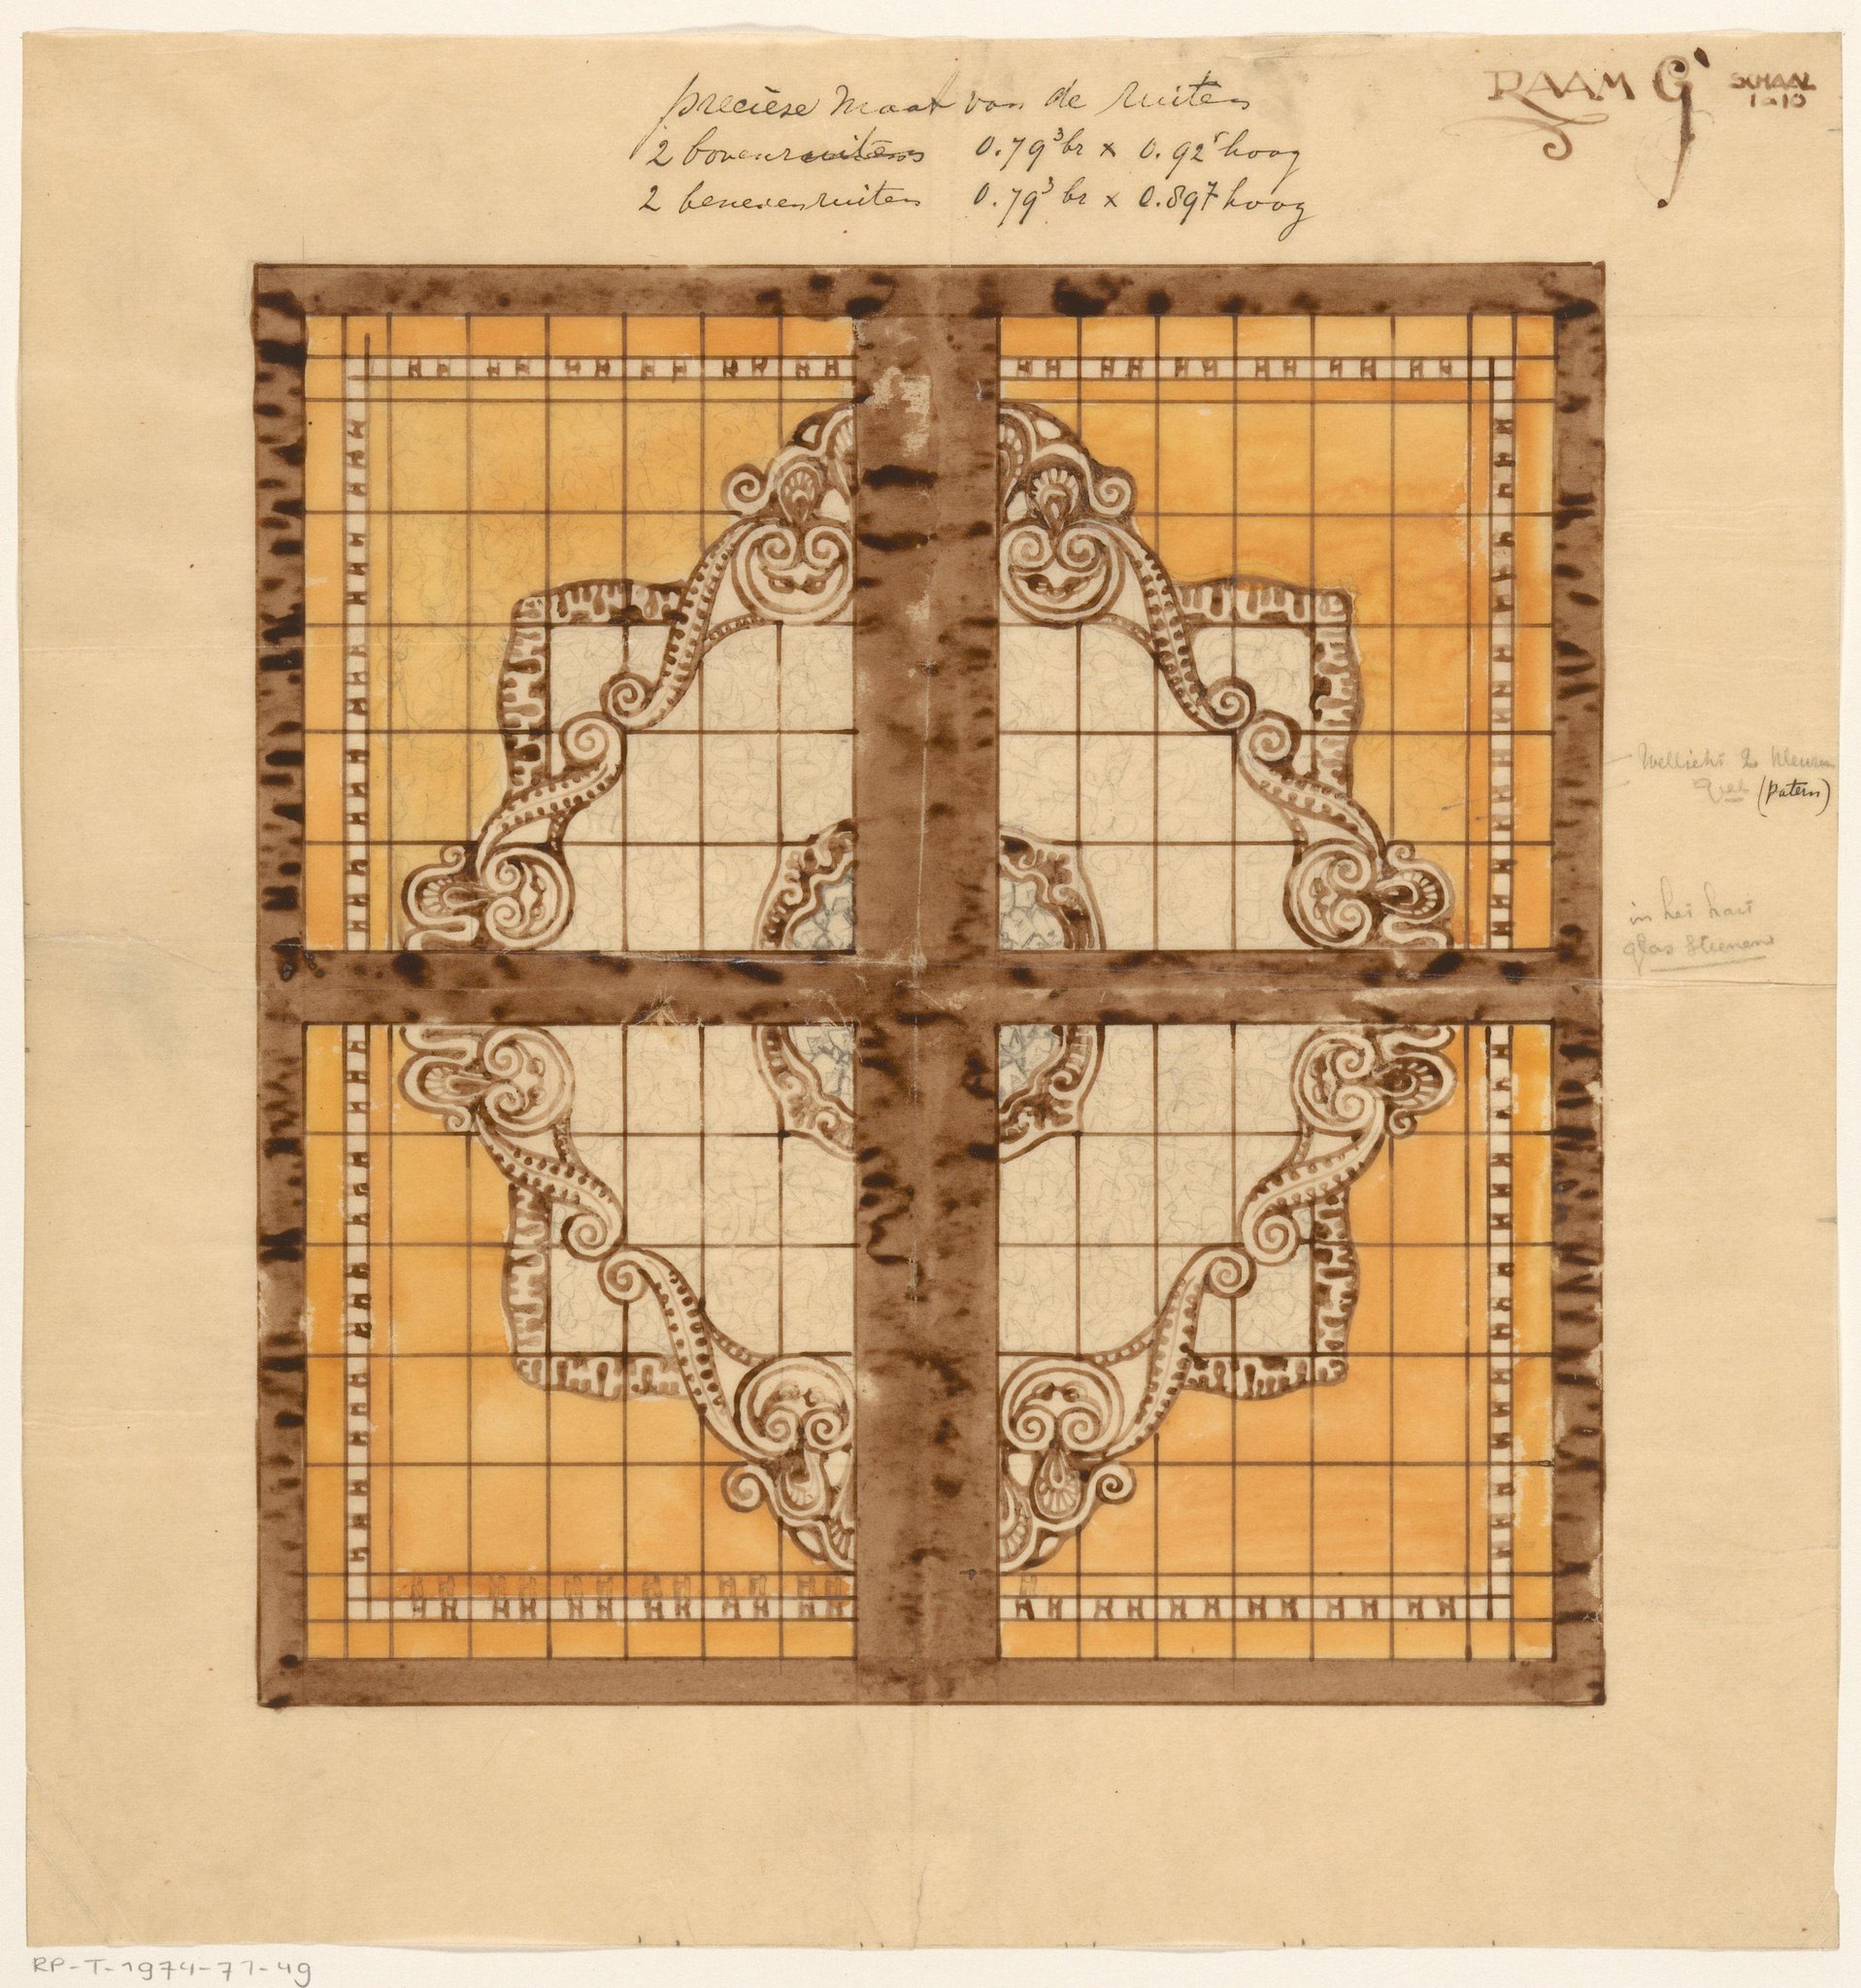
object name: drawing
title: Ontwerp voor een glas in loodraam met een bloemvorm met rolwerk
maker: Anonymous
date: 1907-1930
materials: ink, pencil, paper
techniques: brush, pen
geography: amsterdam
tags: ribbon, scroll, banderole ~ ornament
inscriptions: collector's mark: ‘R:MVS’, inscription